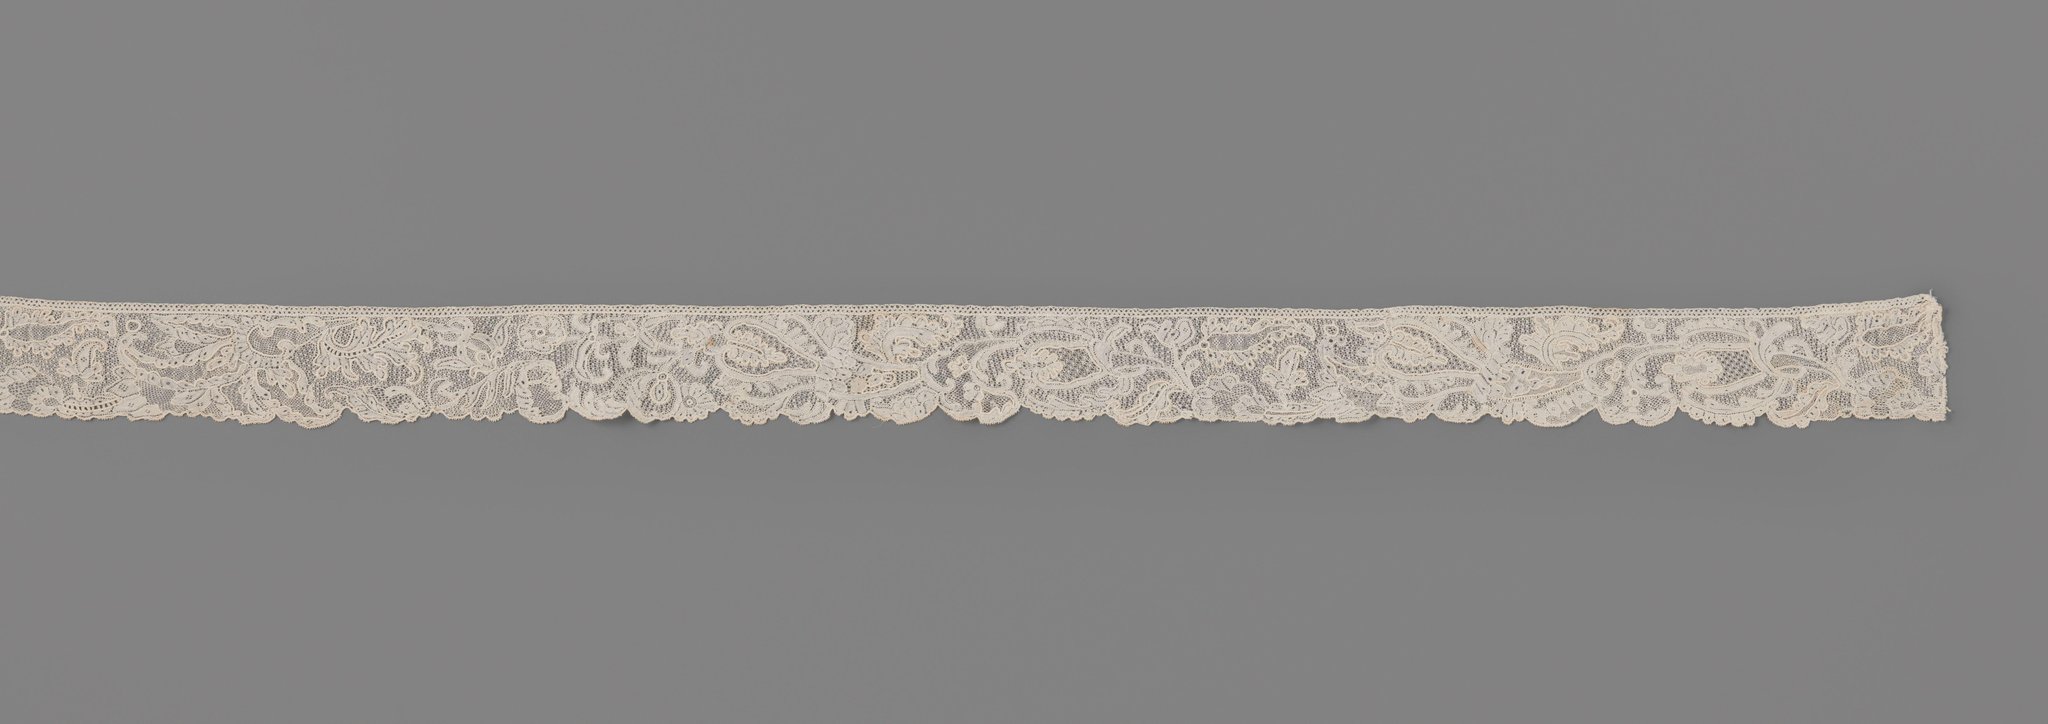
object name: headdress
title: Strook naaldkant met acanthusbladeren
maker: Anonymous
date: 1720-1730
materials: lace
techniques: lace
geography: france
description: Strook naturelkleurige naaldkant: Régence-kant, behorend bij een muts. Patroon met acanthusbladeren en weelderige bloemen, op een maasgrond versierd met vierkante moesjes. Volwerk met uitsparingen en veelsoortige siersteken. Reliëfcontouren met festonsteken.